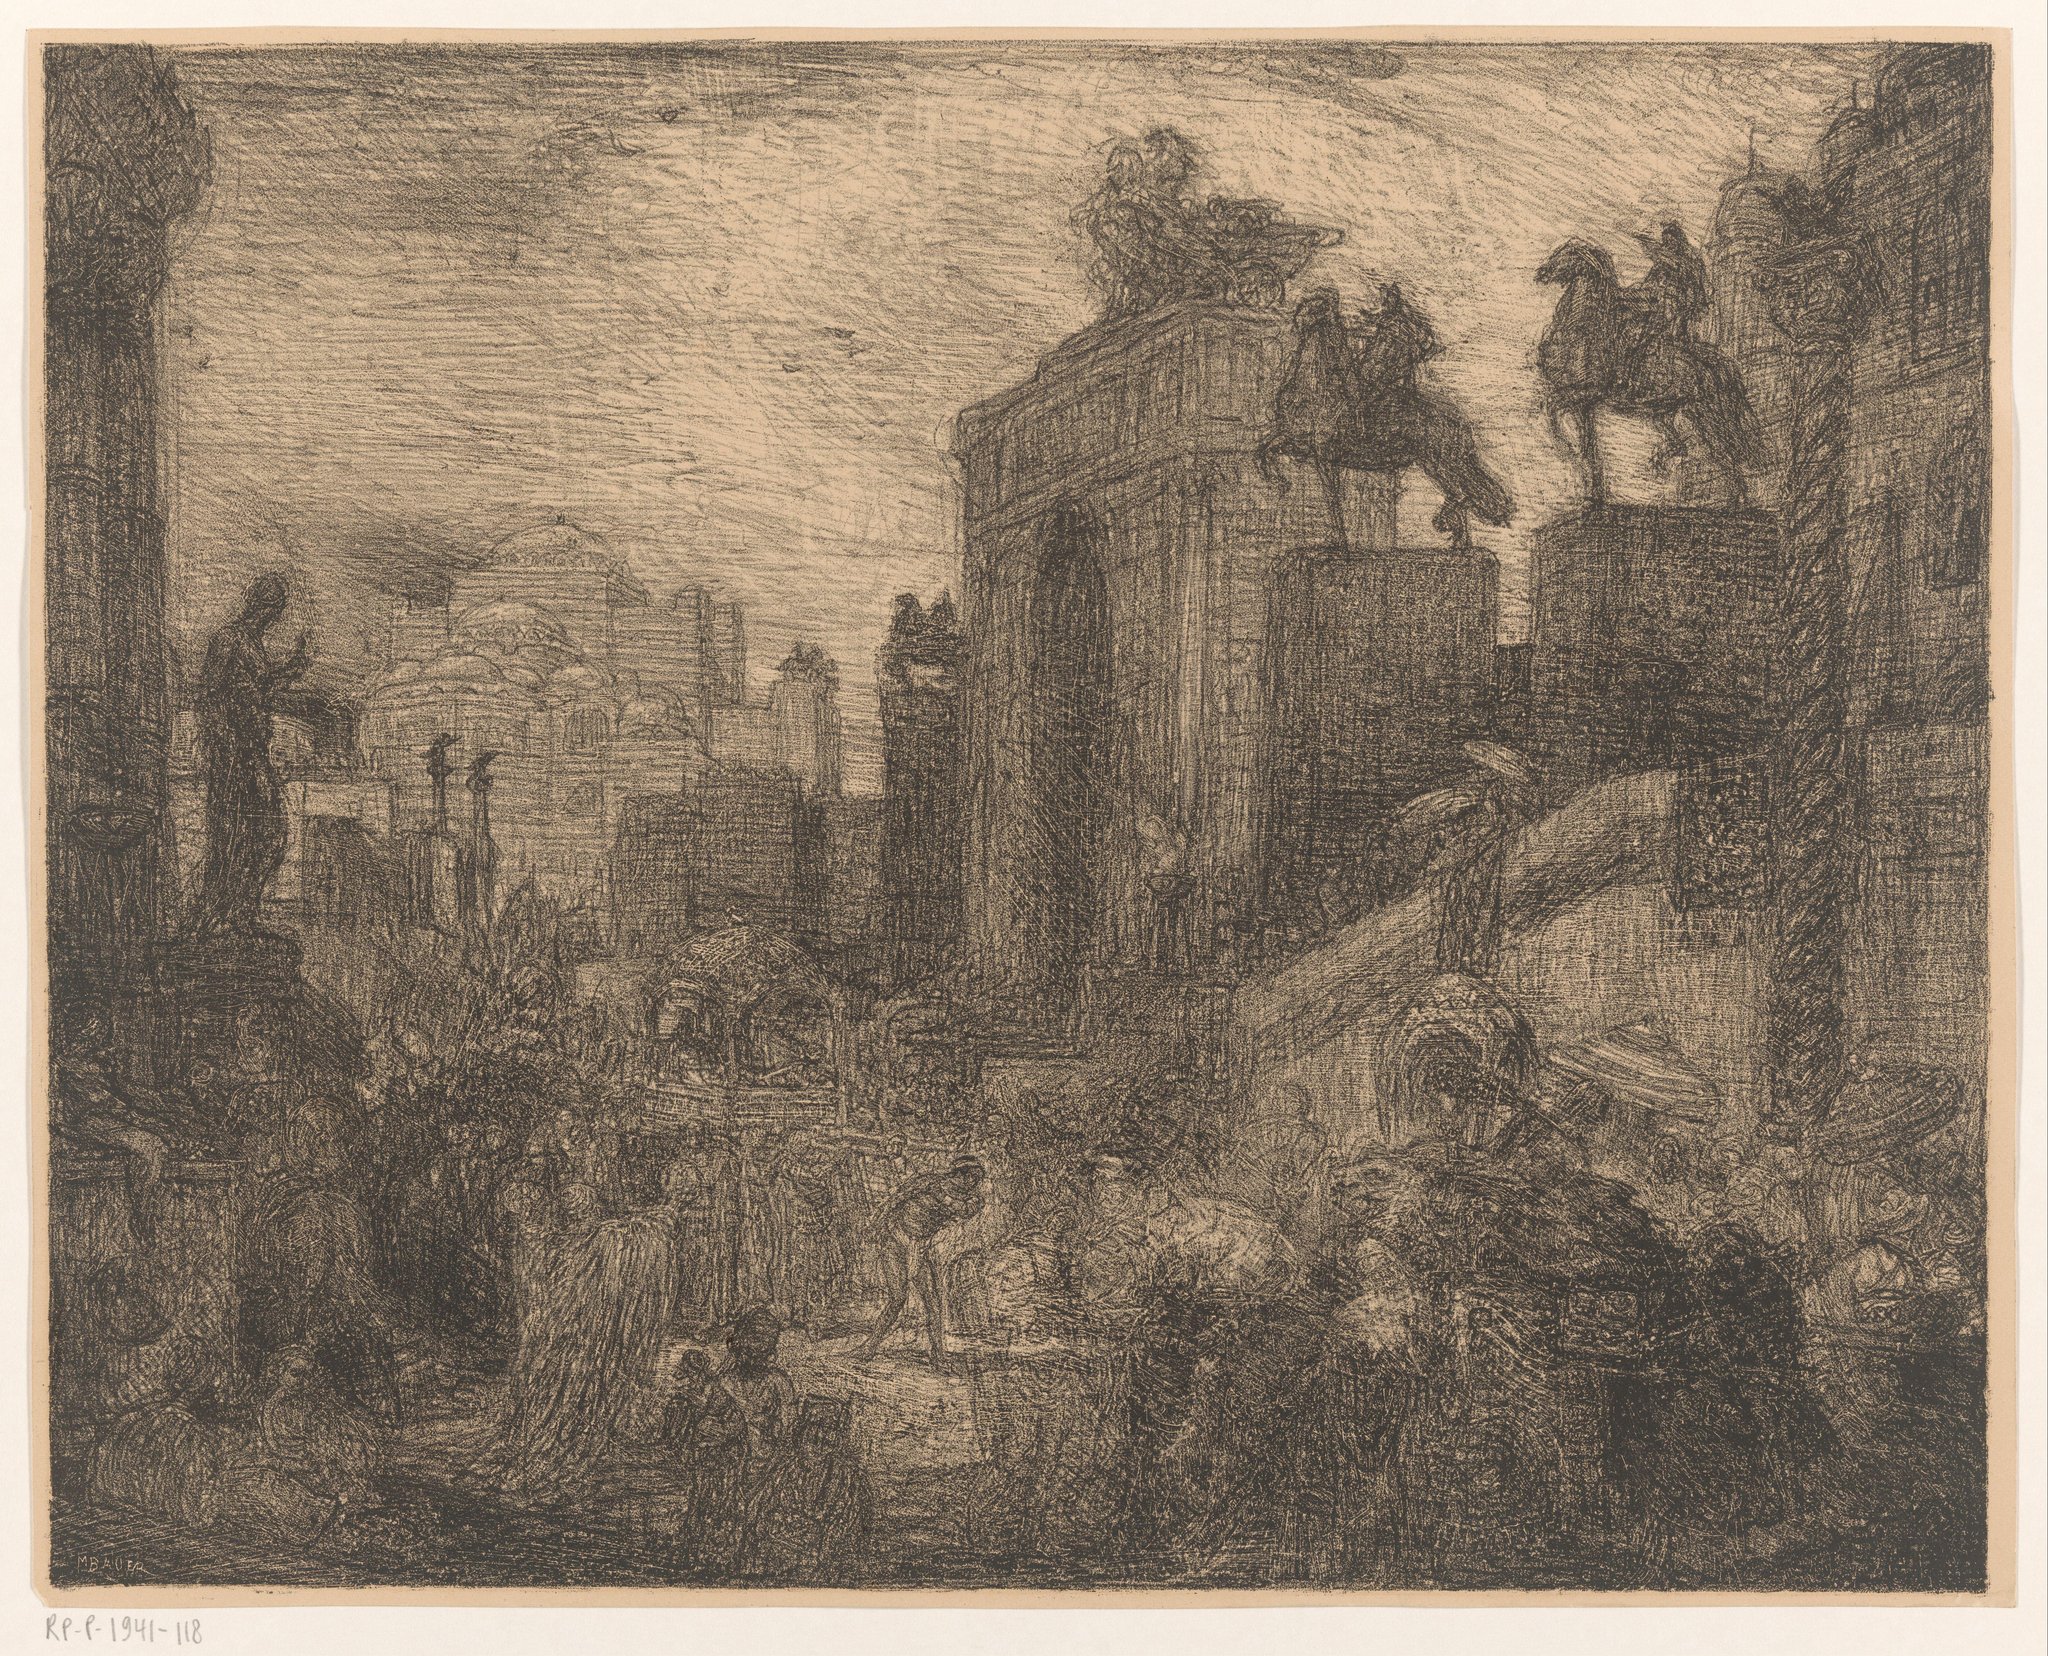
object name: print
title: Optocht met draagkoets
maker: marius bauer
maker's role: draughtsman, print maker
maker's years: 1867-1932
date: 1877-1932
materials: paper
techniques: lithograph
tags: (carrying a person on a) litter, stretcher, city-view in general; 'veduta', triumphal arch, triumphal column with helical friezes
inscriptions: collector's mark: Lugt 2760, collector's mark: Lugt 2228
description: Figuren dragen een draagkoets over een plein. Rechts een triomfboog, een erezuil een meerdere ruiterstandbeelden. Links op de achtergrond een gebouw met meerdere koepels.